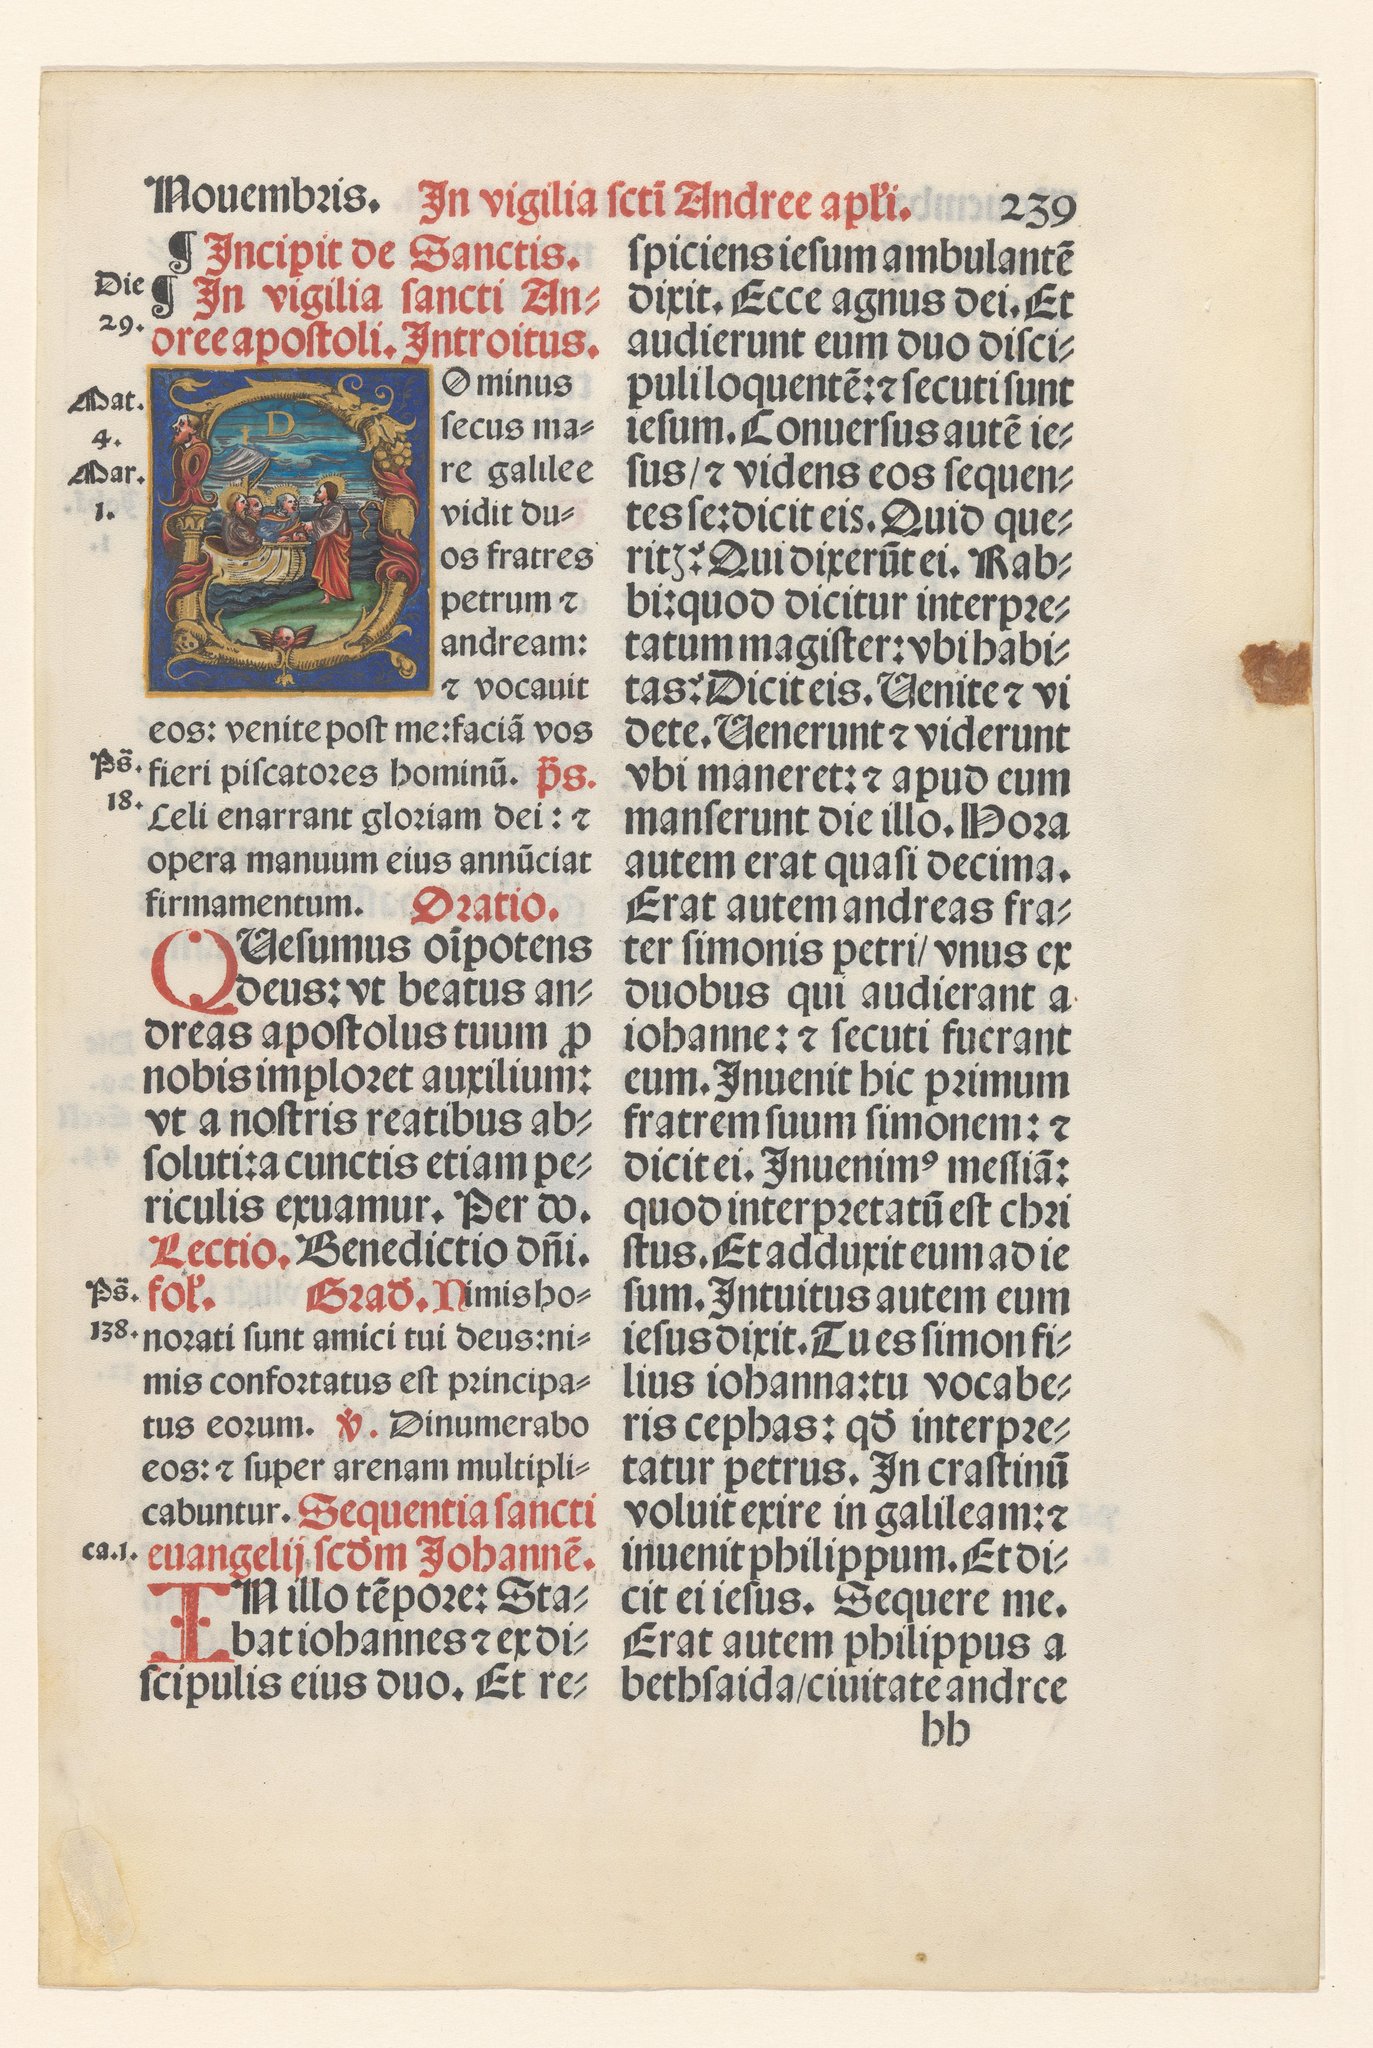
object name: text sheet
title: Blad uit een getijdenboek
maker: Anonymous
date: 1450-1499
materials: paint, ink, paper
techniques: brush, letterpress printing, pen